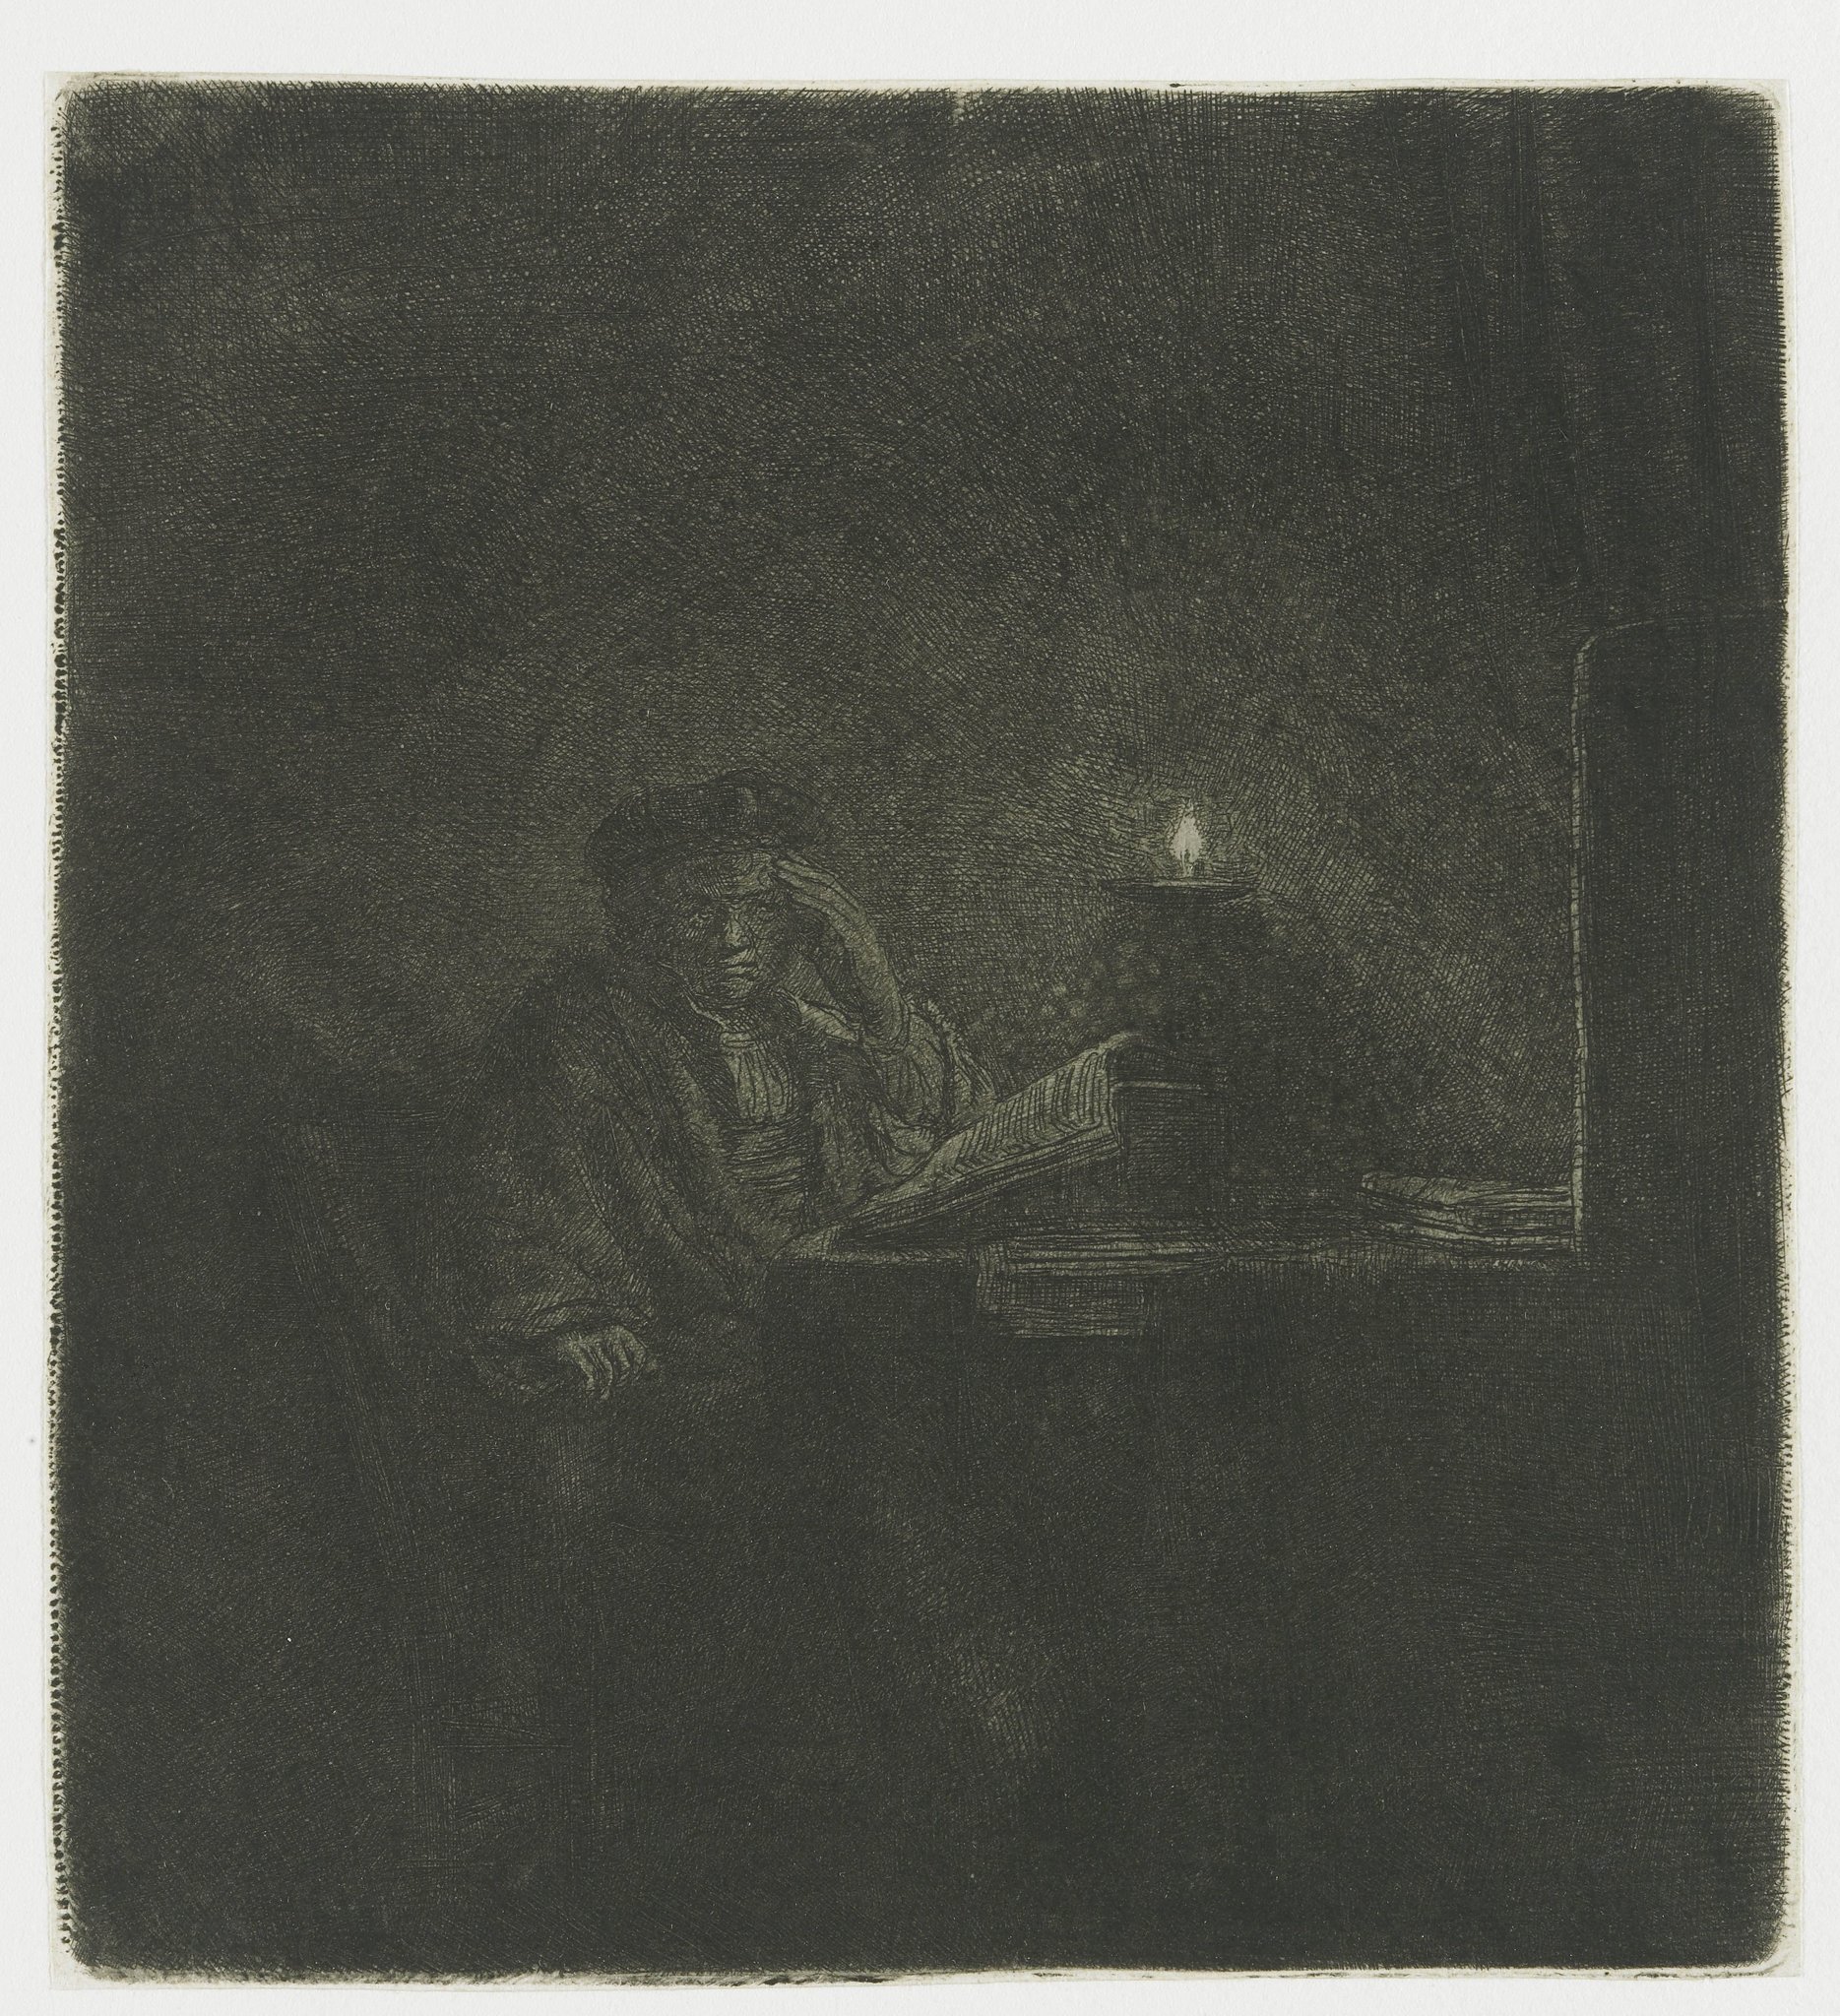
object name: print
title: Student at a table by candlelight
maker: rembrandt van rijn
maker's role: draughtsman, painter, print maker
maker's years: 1606-1669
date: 1642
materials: paper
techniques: etching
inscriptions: mark: Lugt 2165, signature: ‘Rembrandt’